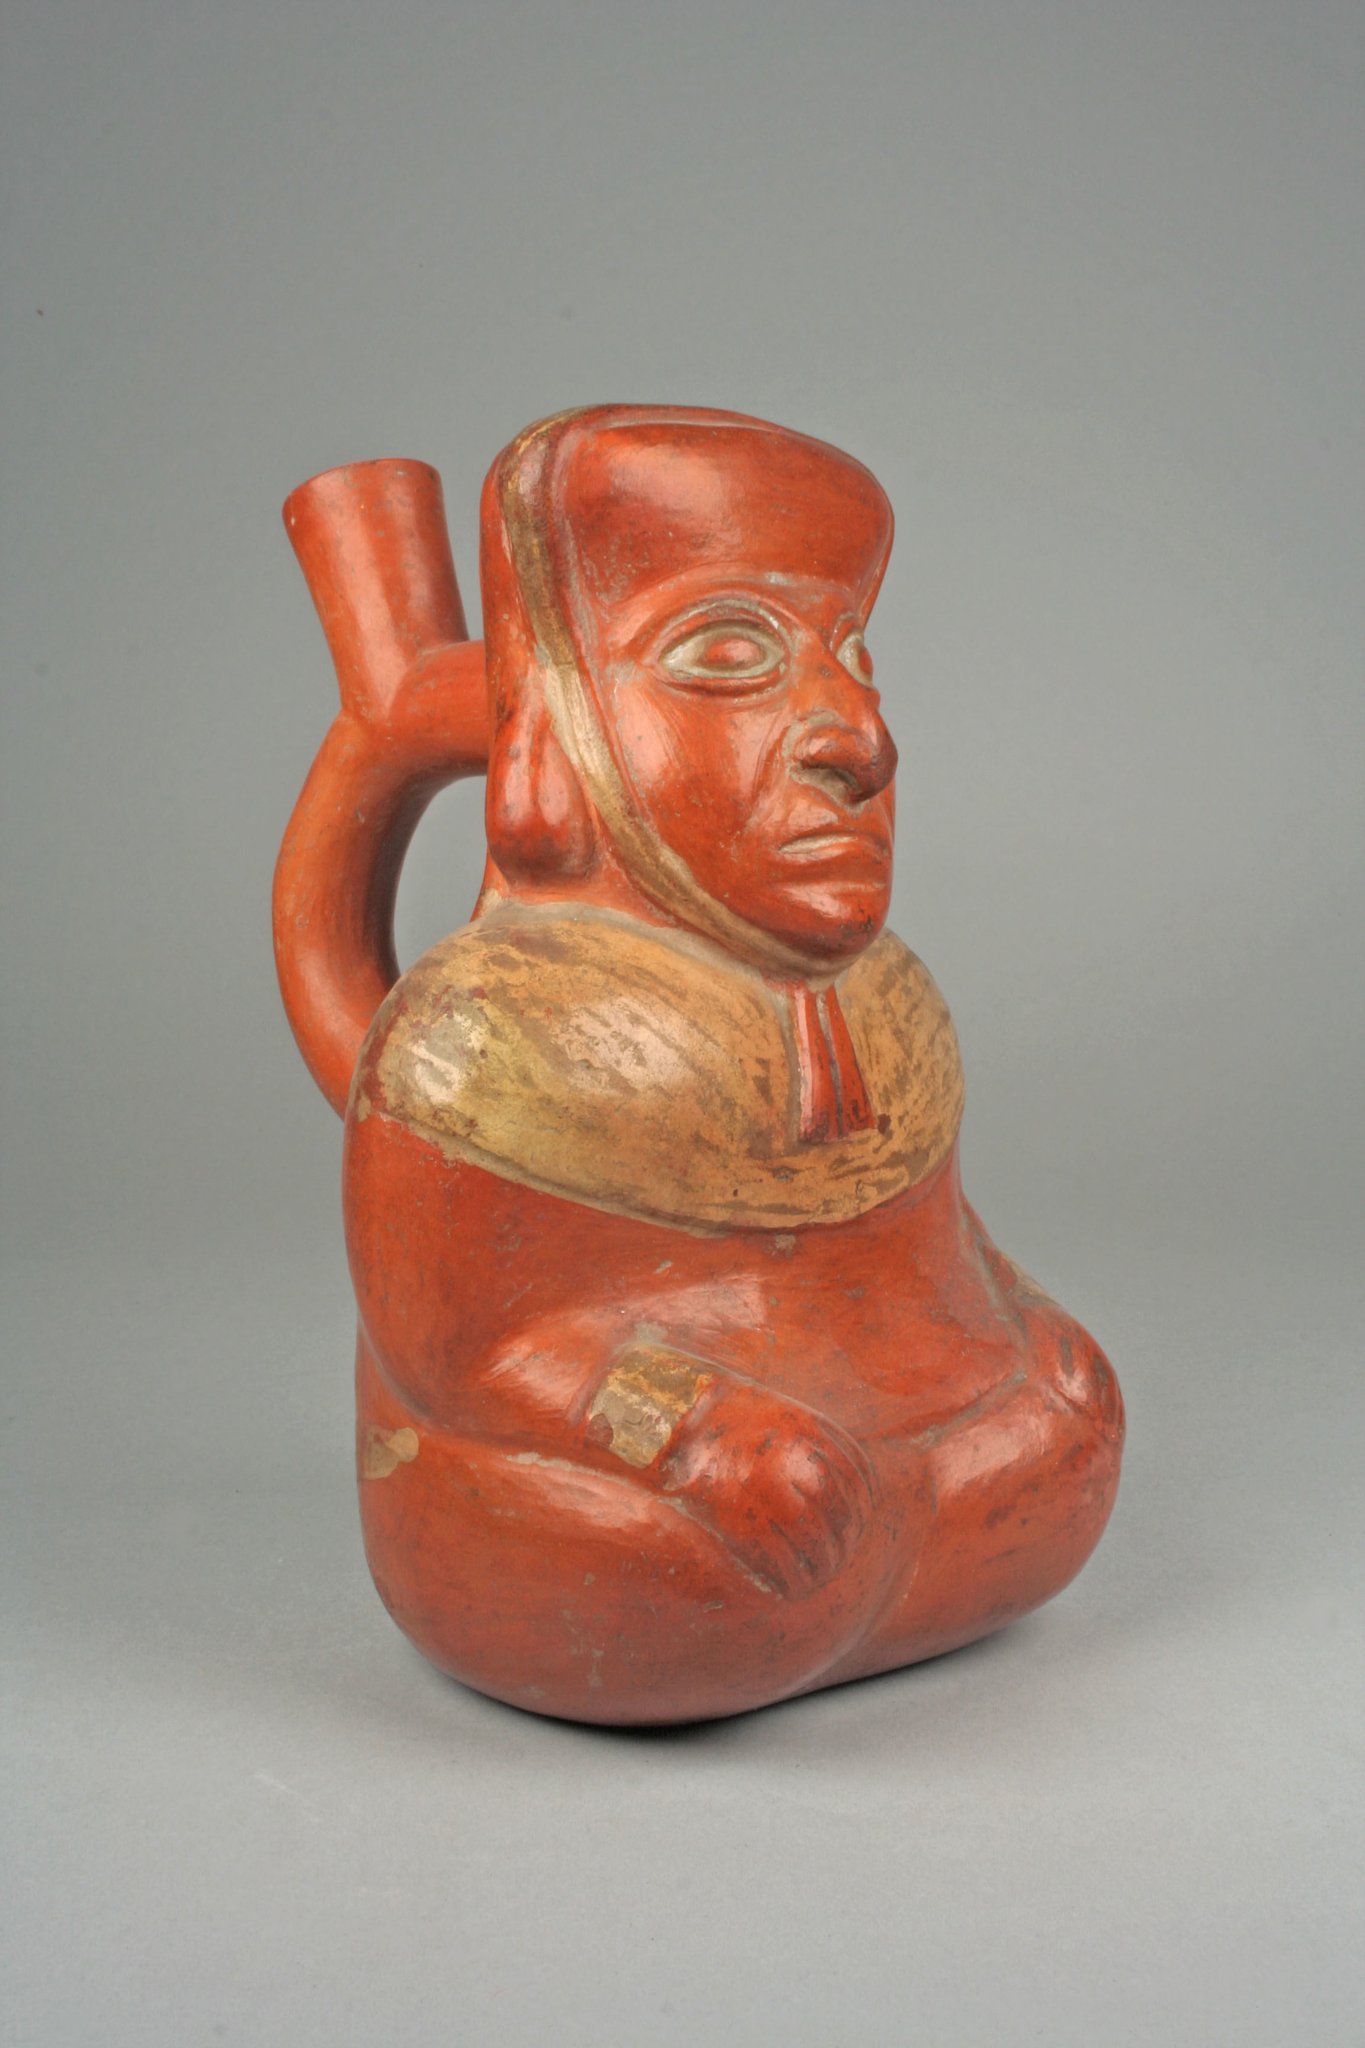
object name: bottle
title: Bottle, Seated Figure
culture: moche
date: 1-300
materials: ceramic, pigment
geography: peru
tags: human figures